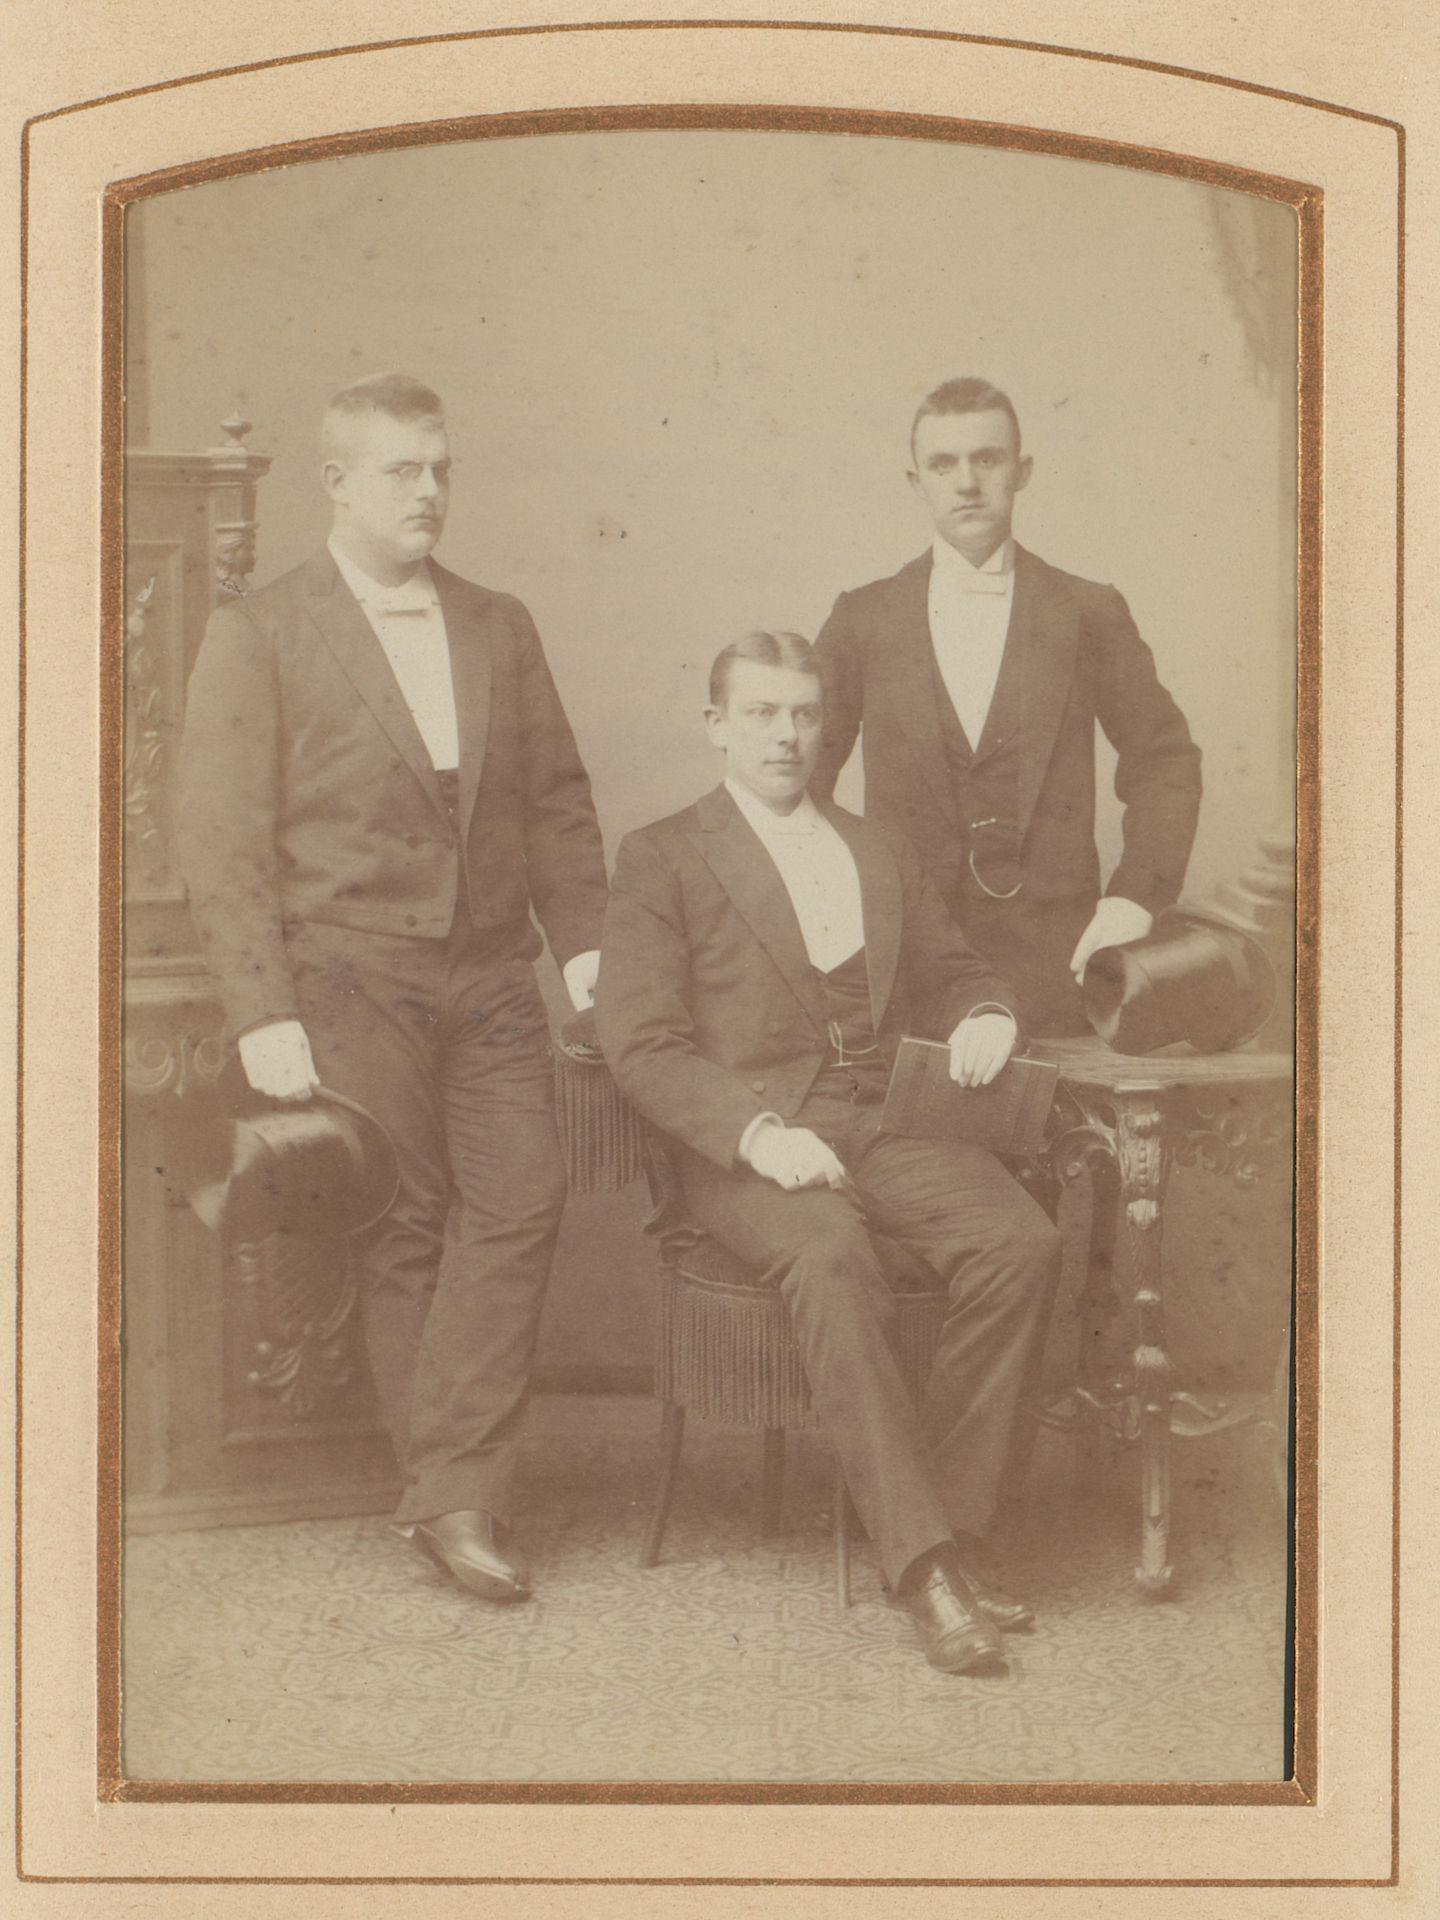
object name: photograph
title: Groepsportret met drie jongemannen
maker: jan goedeljee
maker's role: fotograaf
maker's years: 1824-1905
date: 1870-1900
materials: cardboard, photographic support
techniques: albumen print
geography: leiden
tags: youth, adolescent, anonymous historical persons portrayed in a group, in a group-portrait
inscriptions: inscription: ‘J. Goedeljee/ Hof-Photograaf/ Leiden’